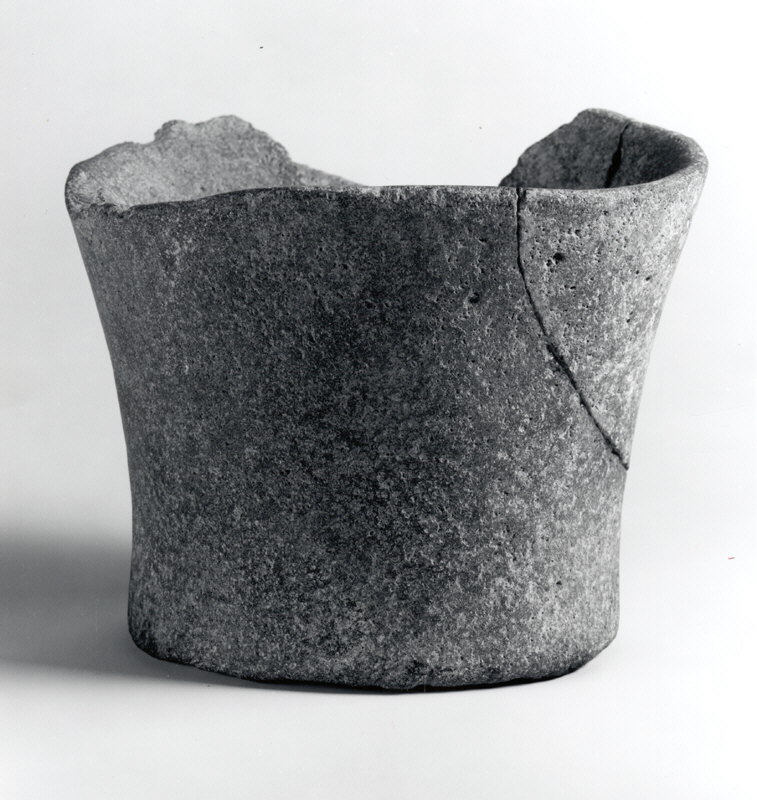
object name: bowl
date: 3500-3300 BCE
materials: stone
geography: levant